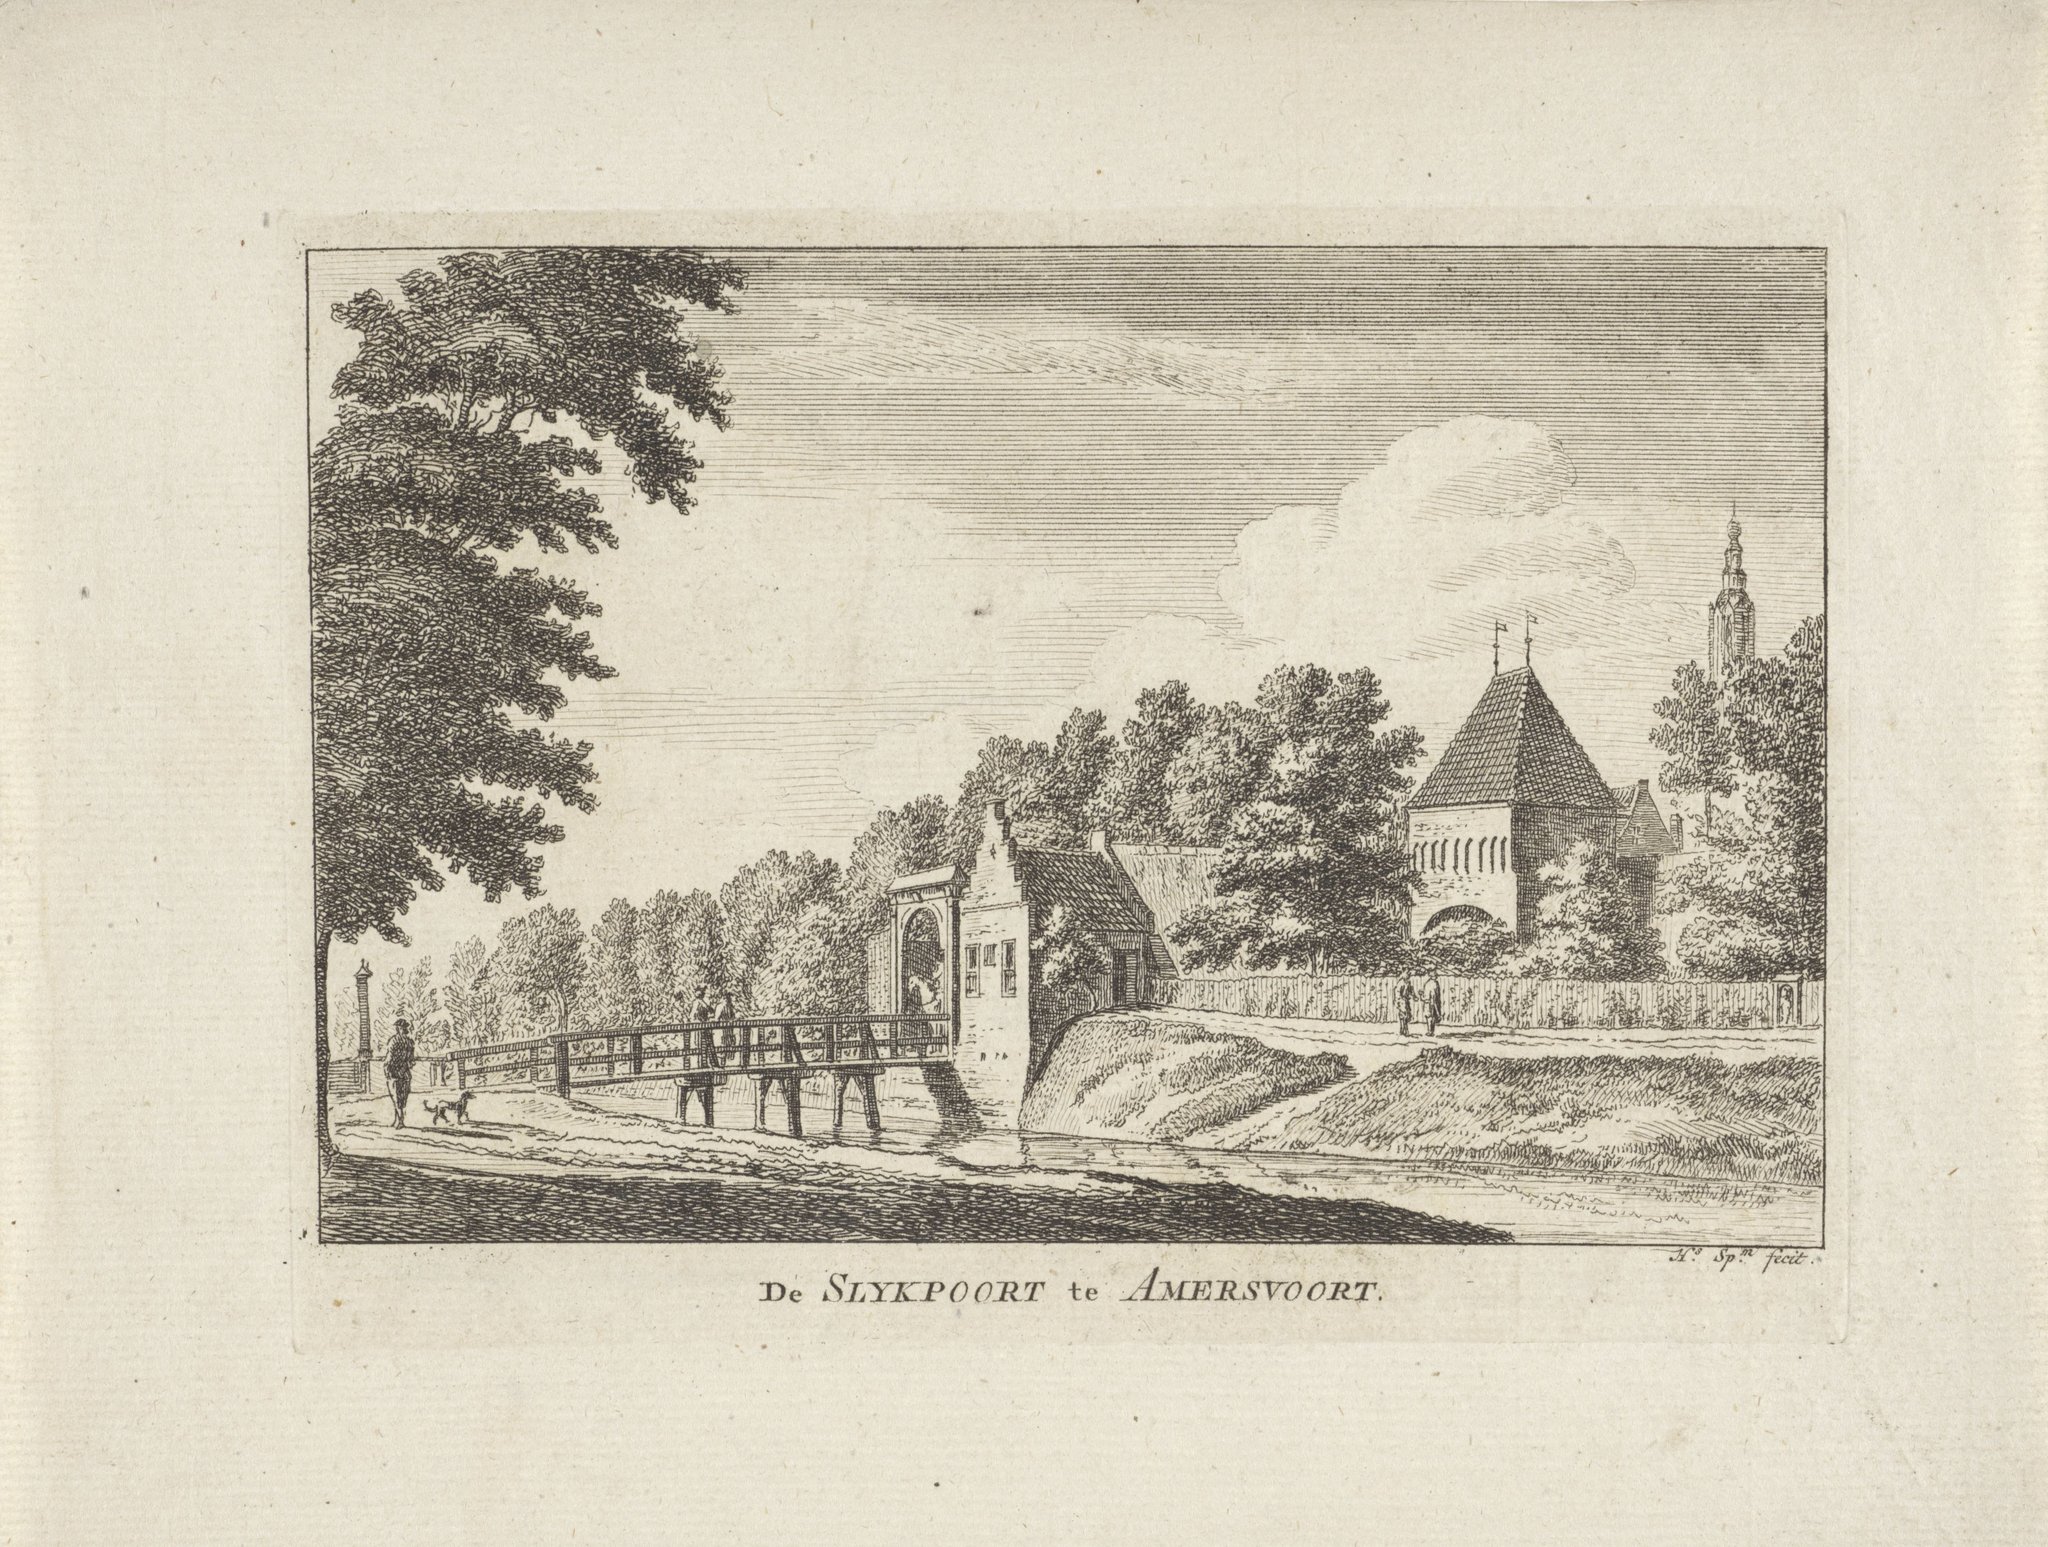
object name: print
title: Gezicht op de Slijkpoort te Amersfoort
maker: hendrik spilman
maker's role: draughtsman, painter, print maker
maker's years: 1721-1784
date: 1742-1784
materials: paper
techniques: engraving, etching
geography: netherlands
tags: bridge, city-gate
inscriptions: title: ‘DE SLYKPOORT TE AMERSVOORT’, collector's mark: Lugt 2228, signature and date: ‘H Sp.m. fecit’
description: Gezicht op de Slijkpoort te Amersfoort met een brug over de singel en helemaal rechts de Onze-Lieve-Vrouwetoren.